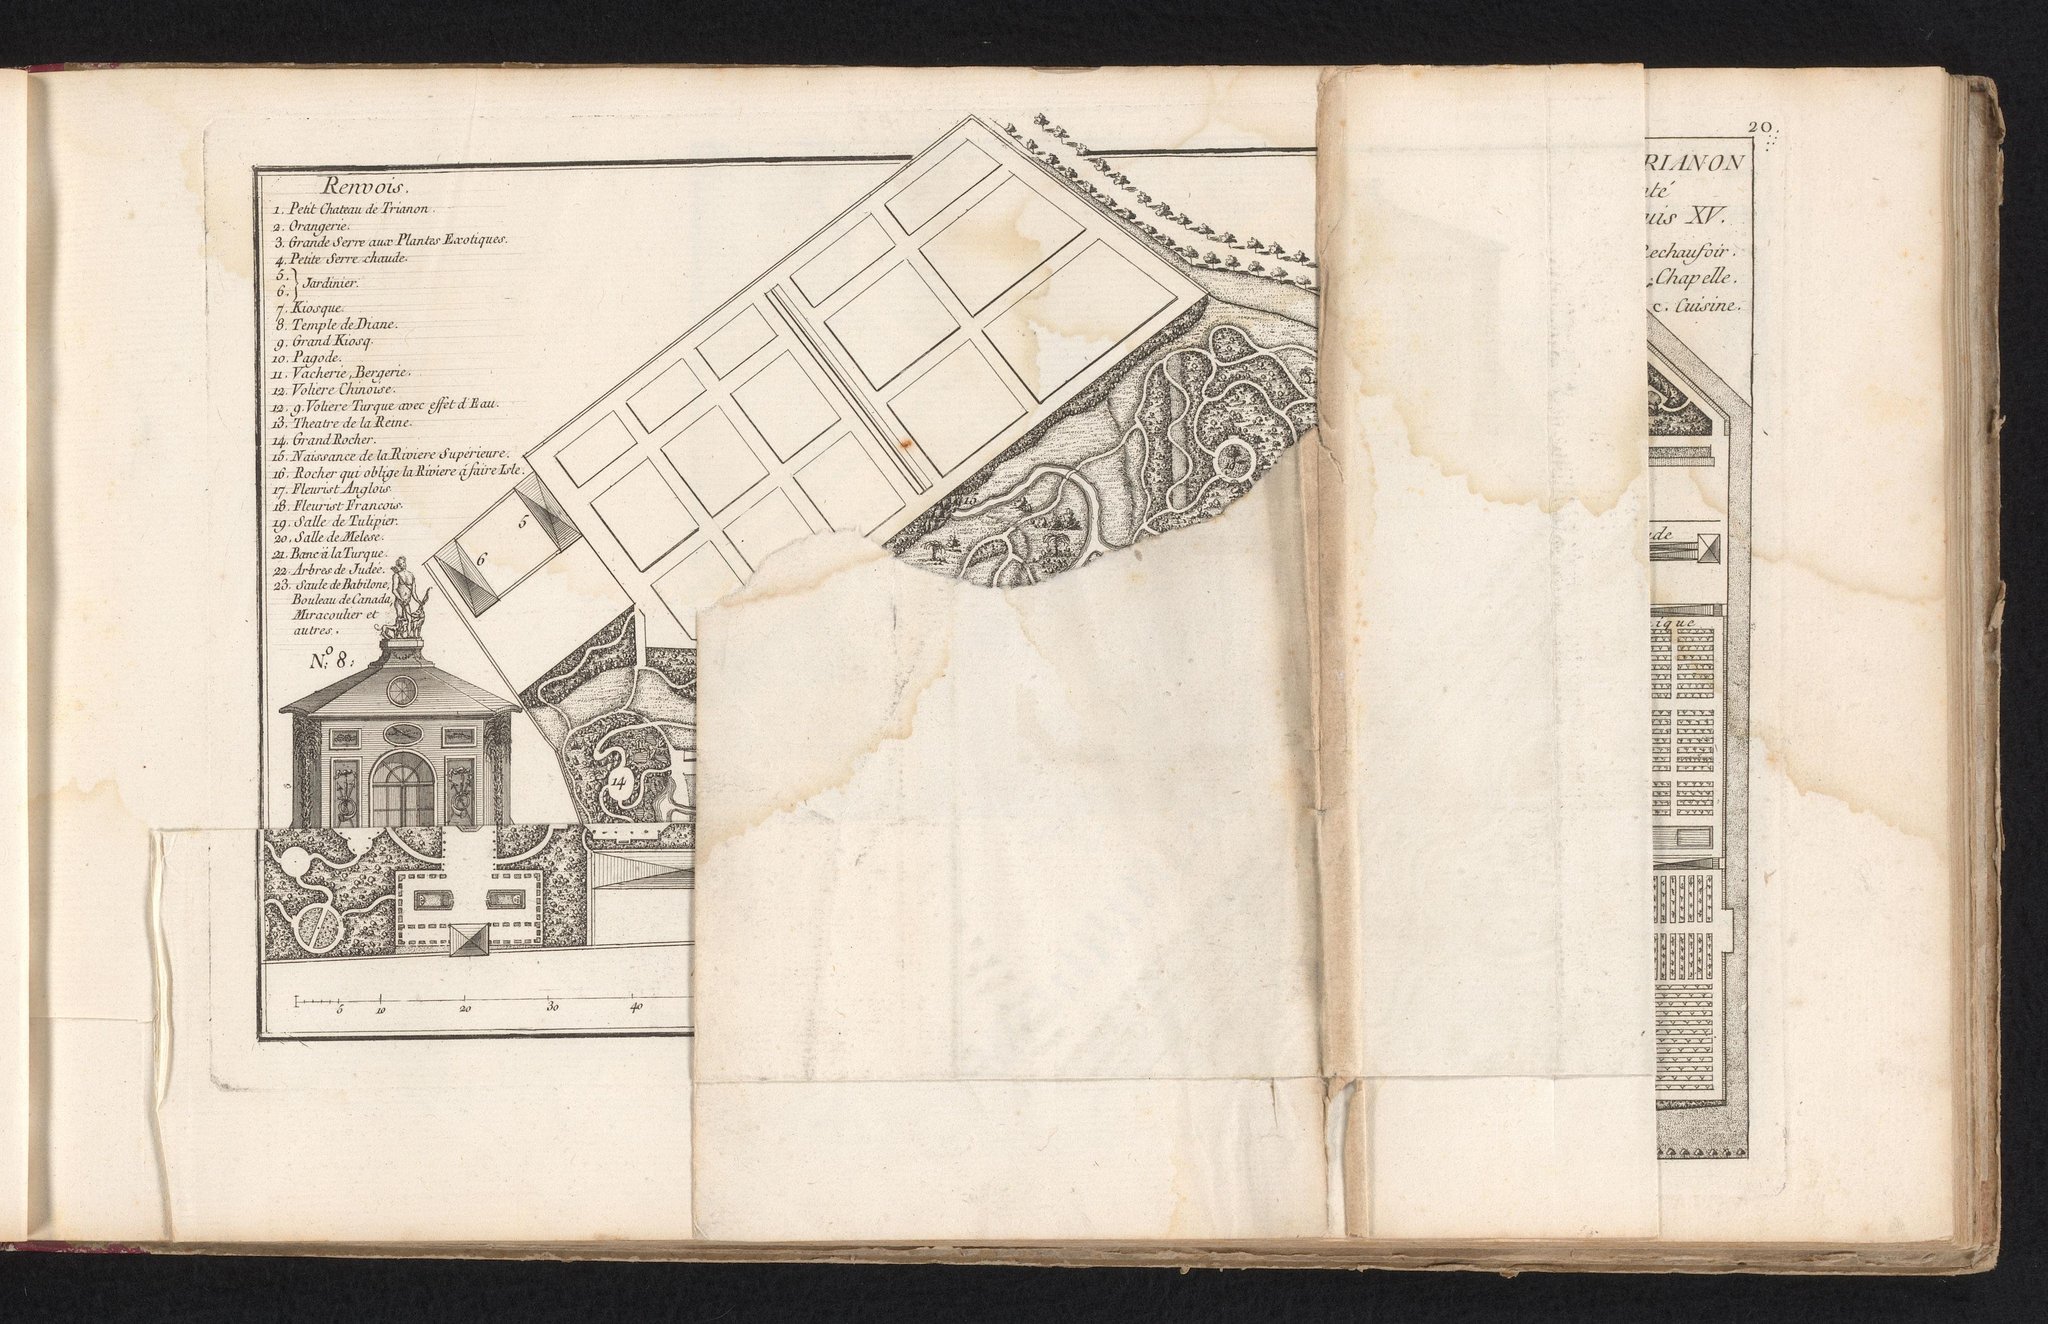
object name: album leaf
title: Projet pour le jardin anglo-chinois du Petit Trianon par Antoine Richard jardinier de la reine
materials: paper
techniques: engraving, etching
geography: paris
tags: park, plan, map of garden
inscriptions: collector's mark: Lugt 2228, collector's mark: Lugt 2760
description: De serie 'Jardins anglo-chinois à la mode' verscheen in totaal in 21 zogeheten 'cahiers' (afleveringen). De huidige prent komt uit het zesde 'cahier'. Het Rijksmuseum Amsterdam bezit drie banden met daarin in totaal zes 'cahiers' van deze reeks. In de documentatie wordt verwezen naar een in de bibliotheek van het Rijksmuseum Amsterdam aanwezige facsimile van het complete werk.